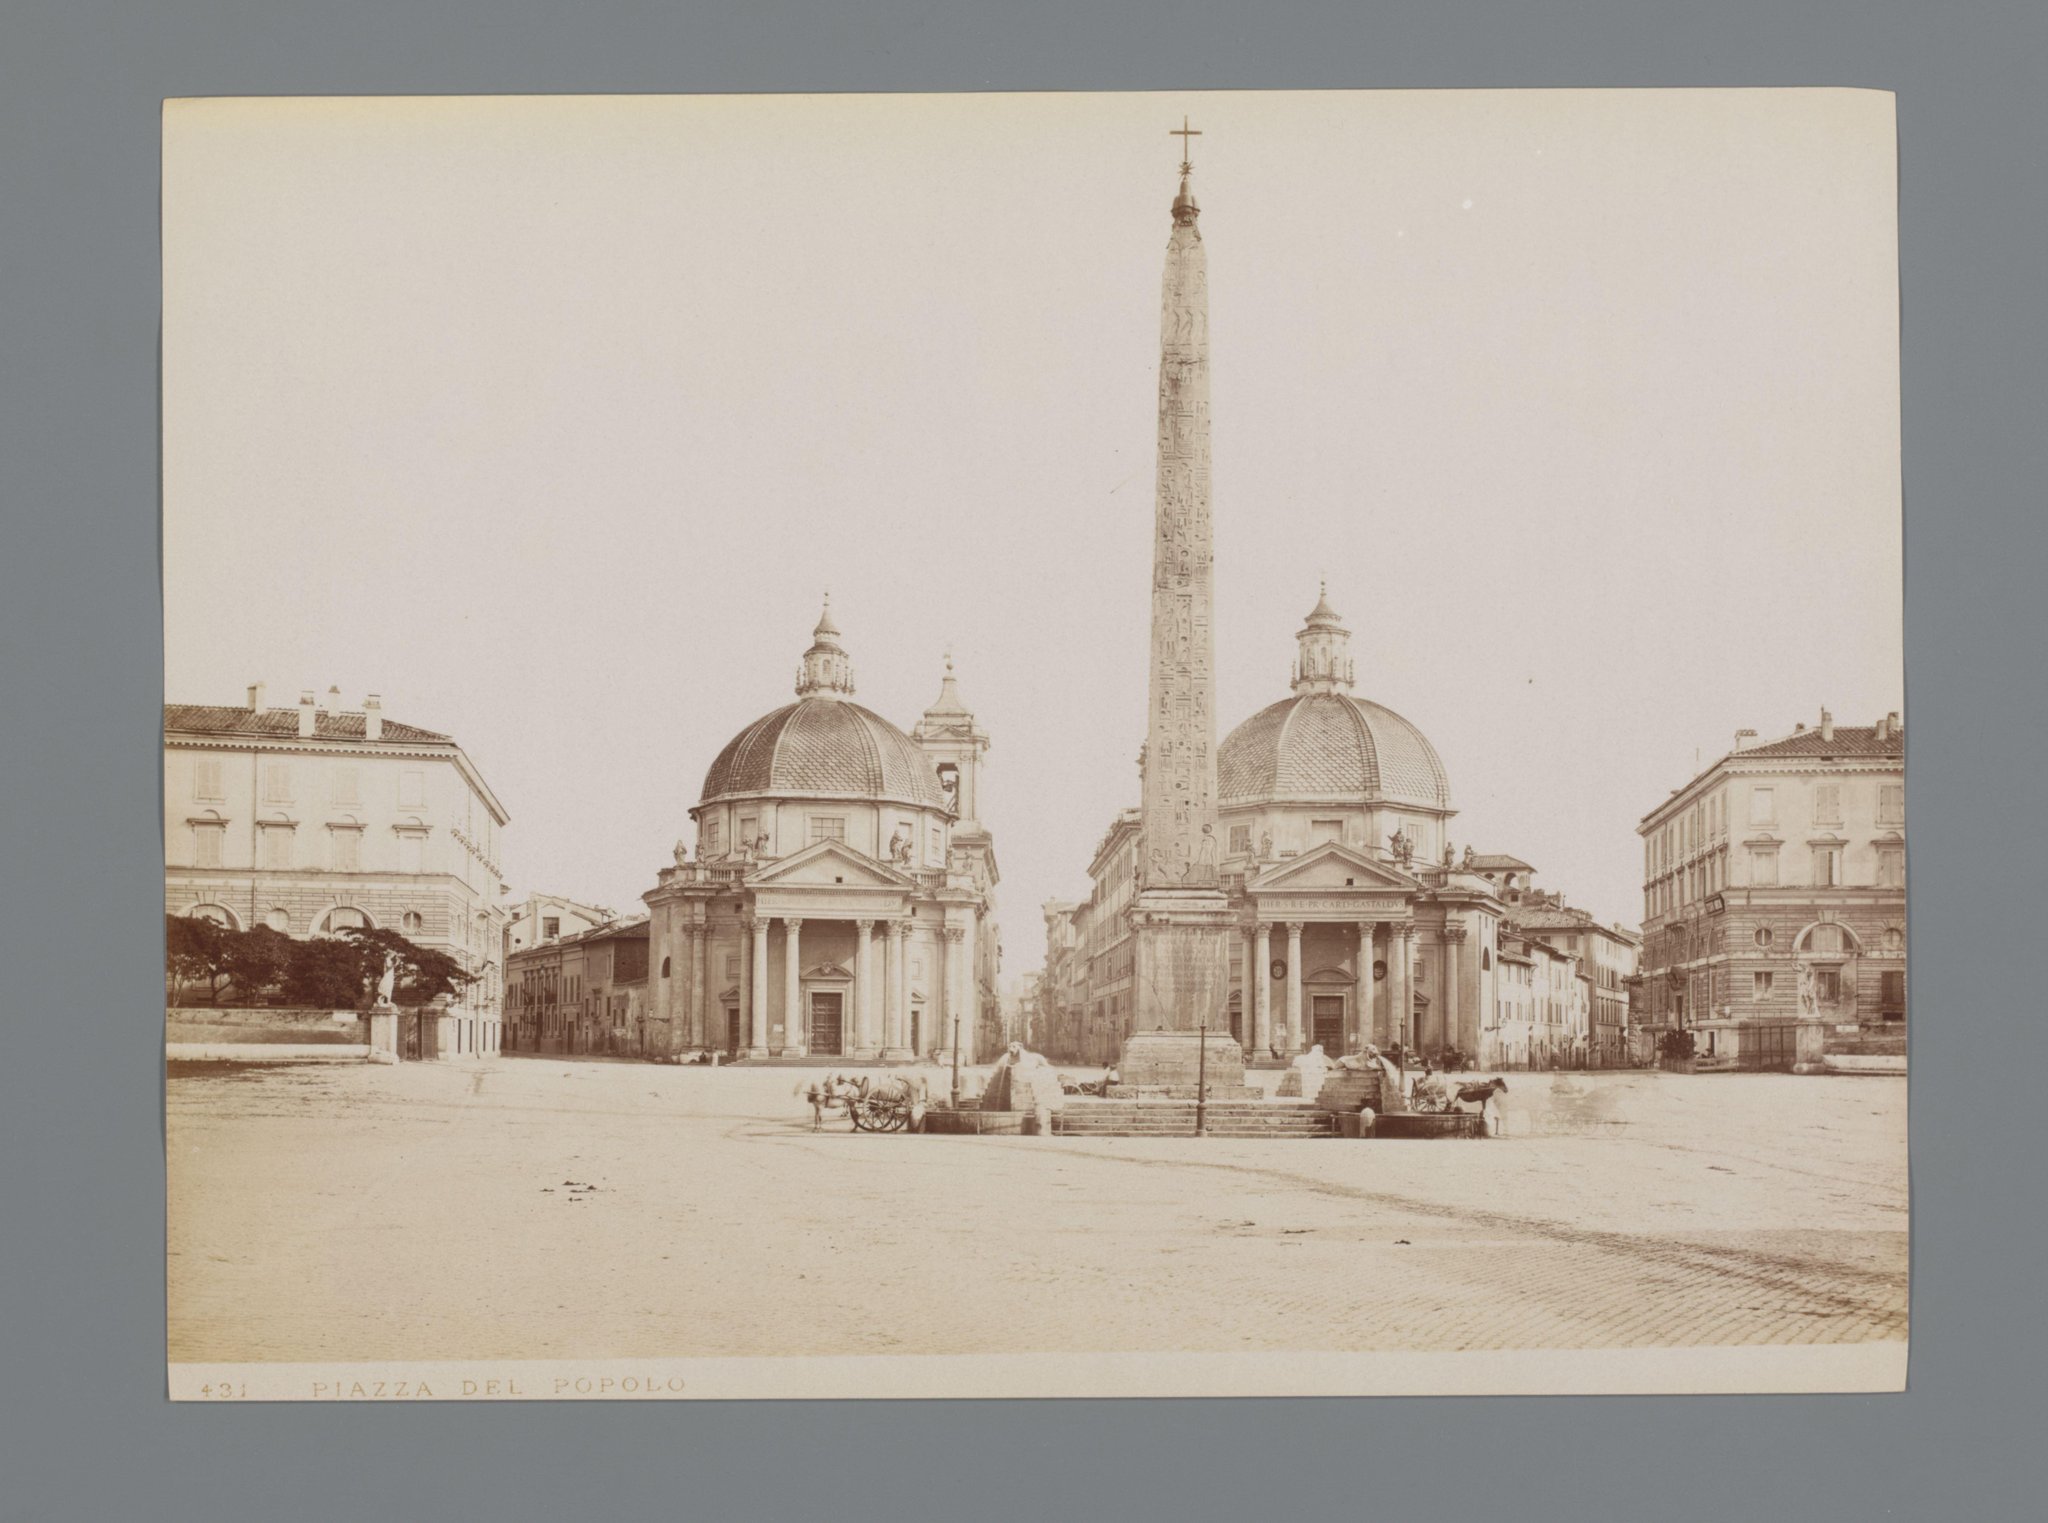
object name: photograph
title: Gezicht op het Piazza del Popolo in Rome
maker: james anderson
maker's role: fotograaf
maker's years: 1813-1877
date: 1851-1900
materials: paper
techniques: albumen print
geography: piazza del popolo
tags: square, place, circus, etc.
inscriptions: number: ‘431’, collector's mark: ‘VOSMAER’